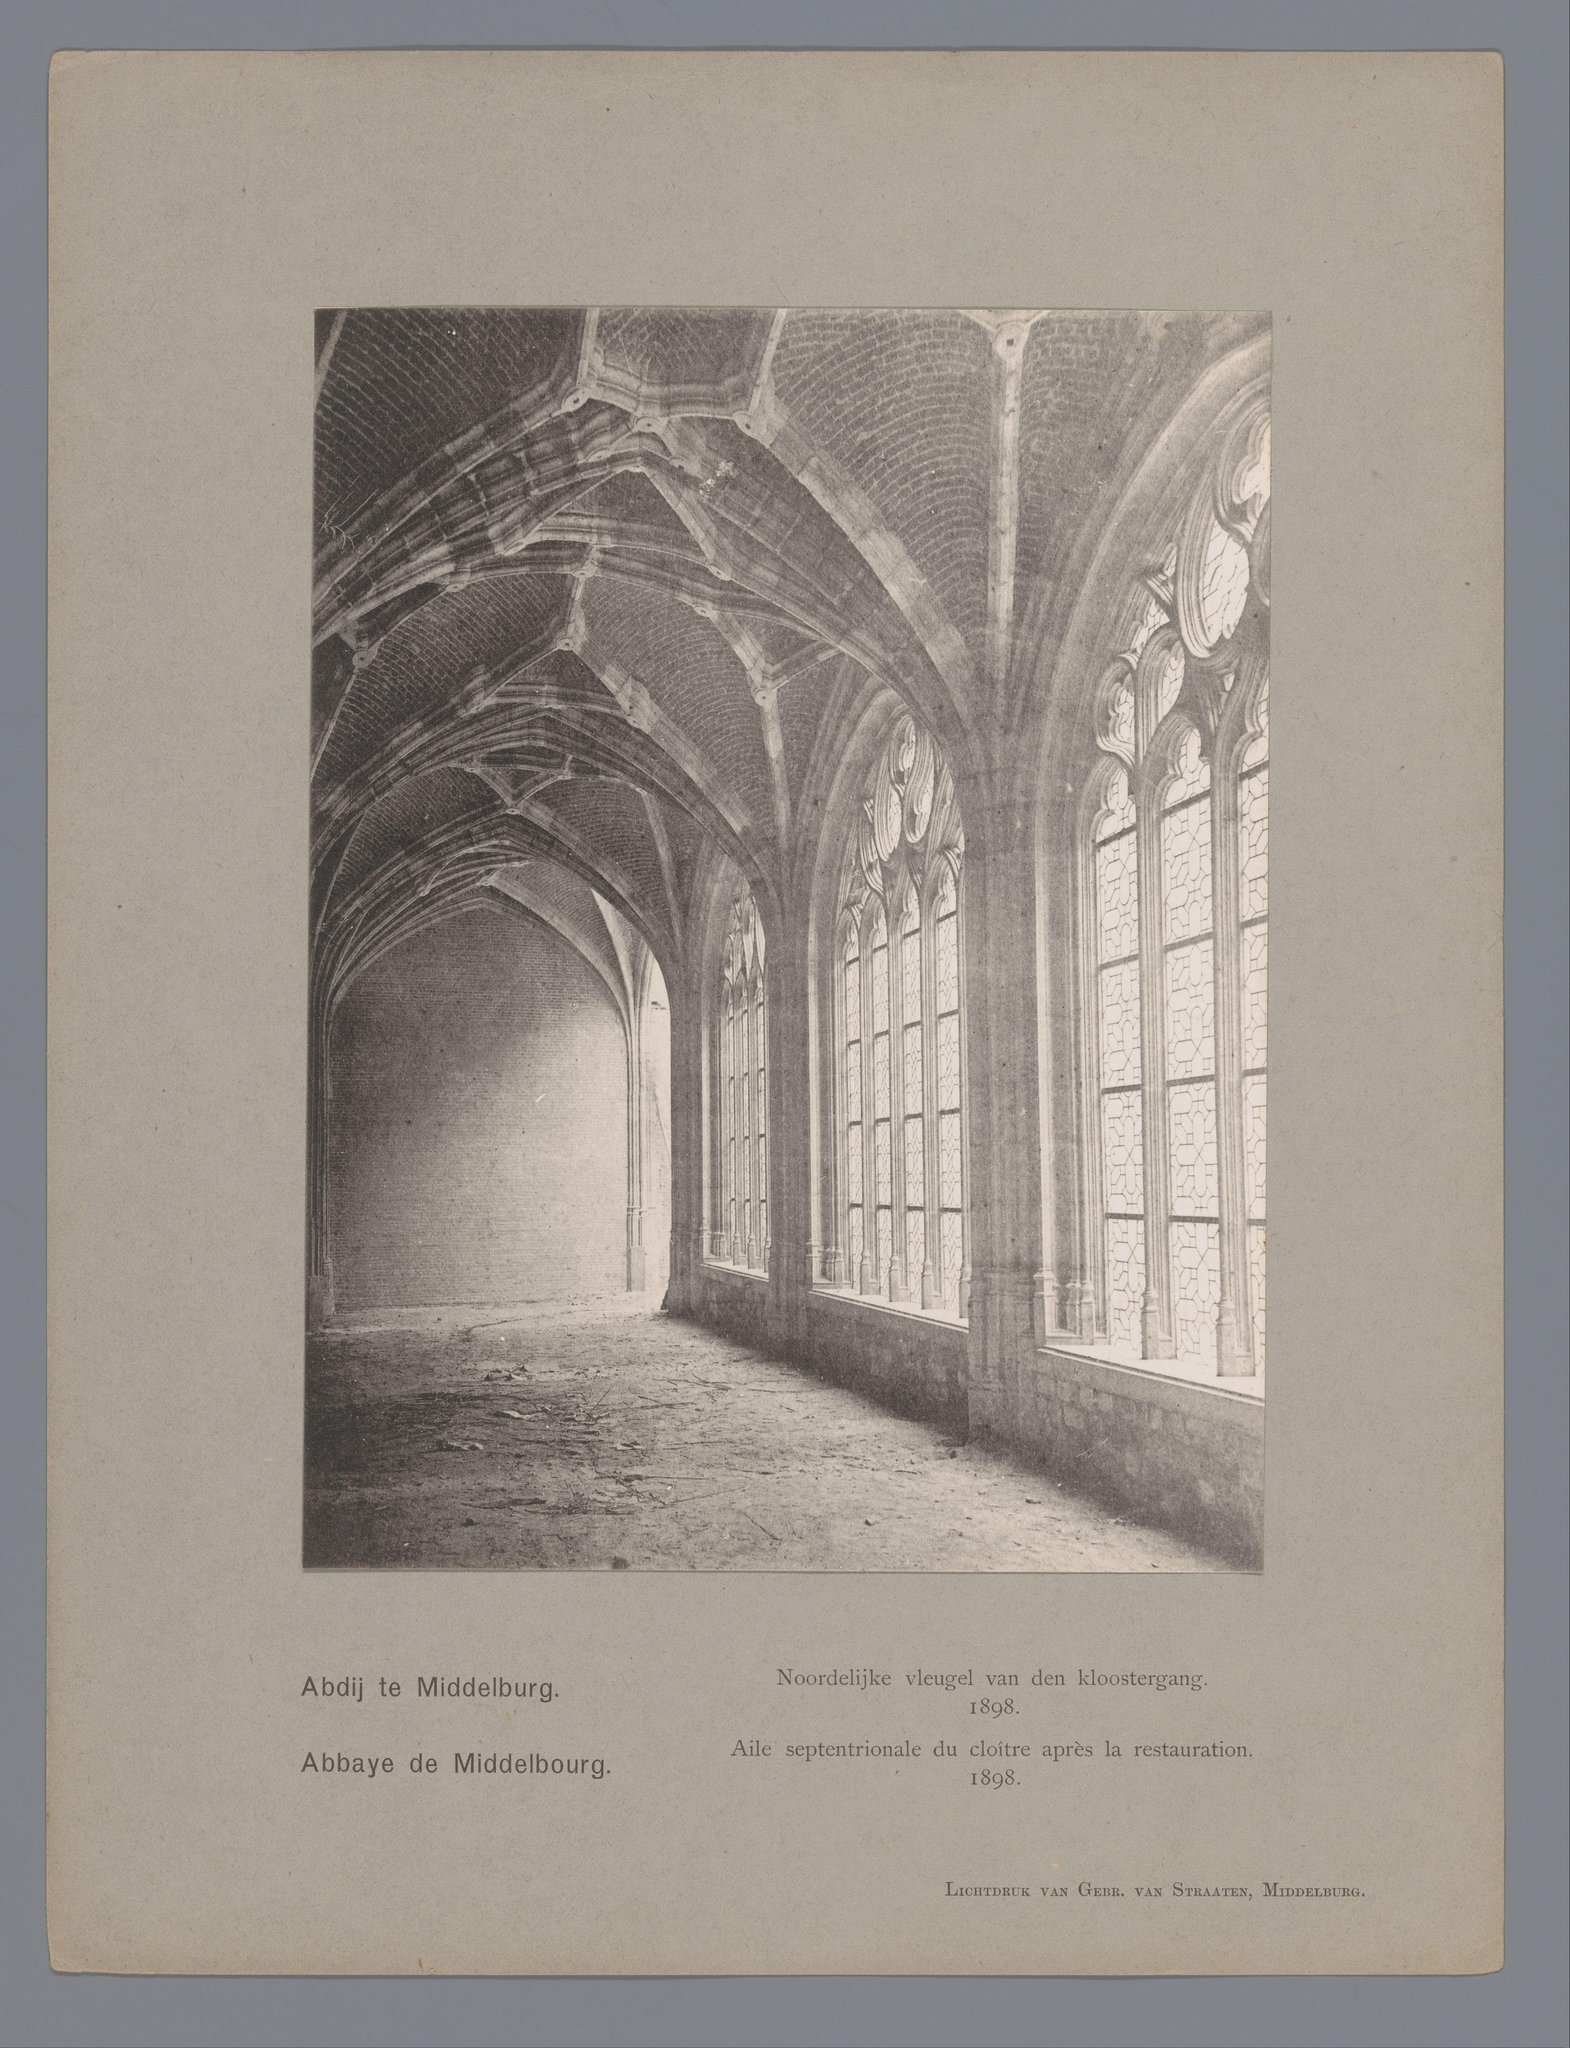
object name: photomechanical print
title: Noordelijke vleugel van de kloostergang van de Abdij te Middelburg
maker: Anonymous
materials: paper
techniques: photograph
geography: middelburg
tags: corridor, abbey, monastery, convent ~ roman catholic church, cloisters ~ monastery